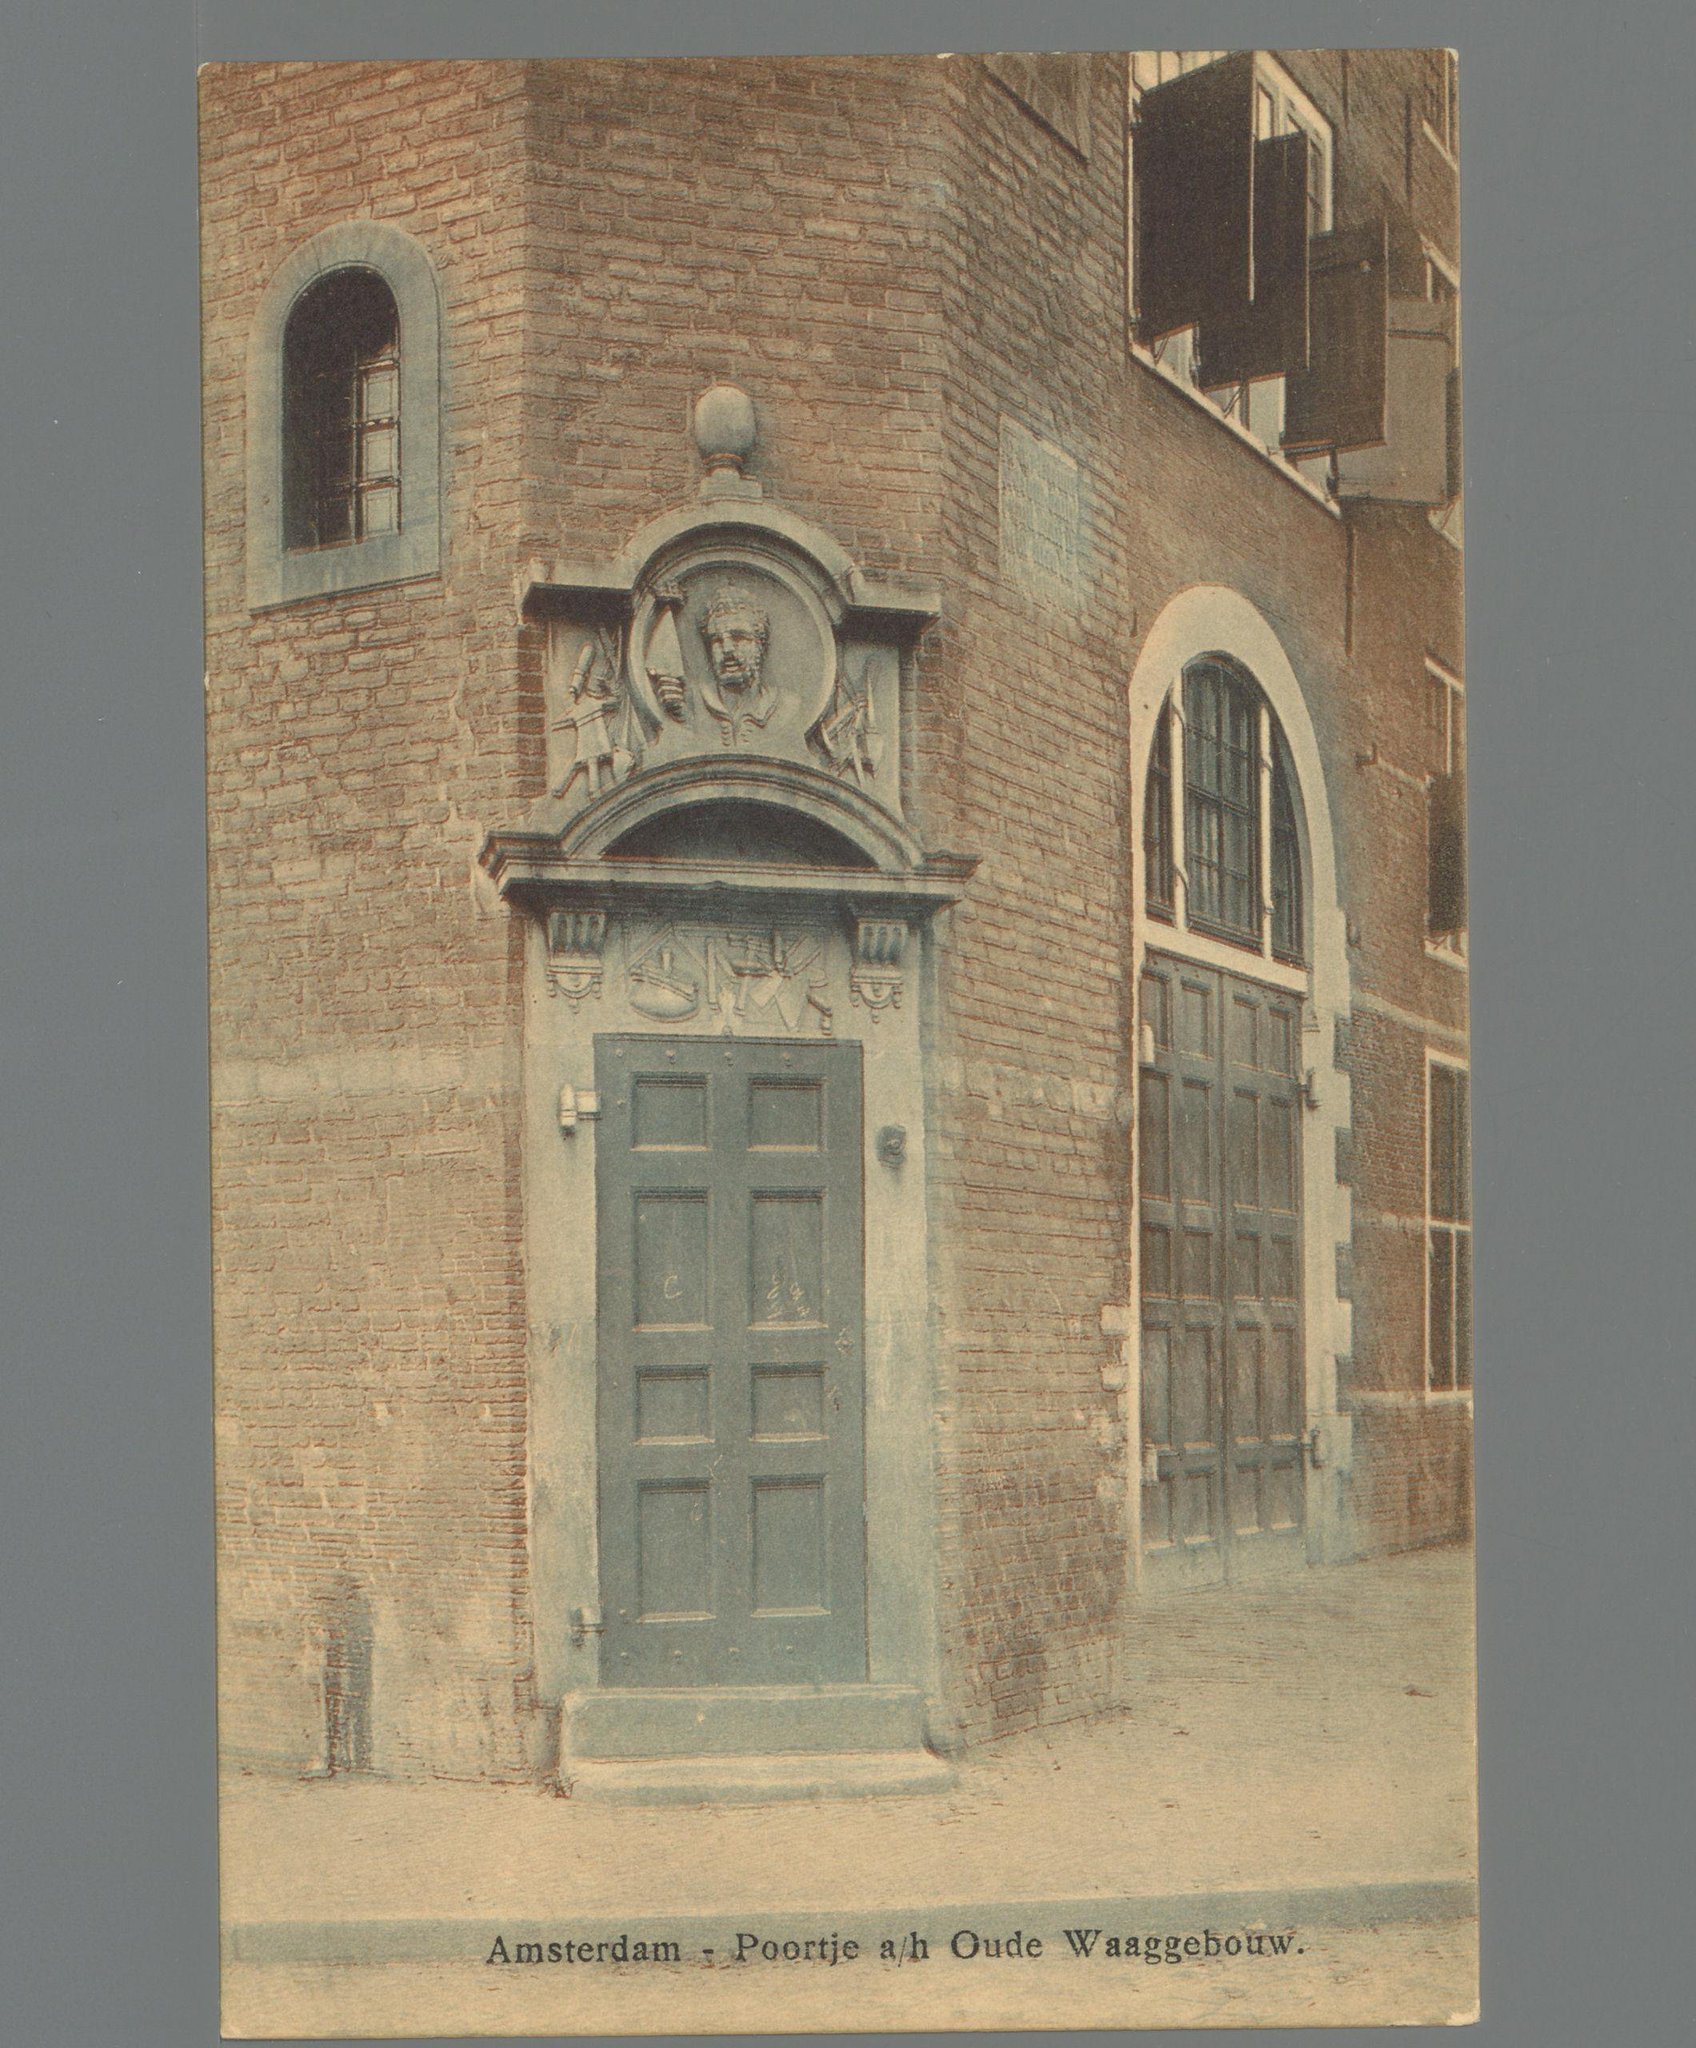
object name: photomechanical print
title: Amsterdam - Poortje a/h Oude Waaggebouw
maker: Anonymous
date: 1910-1912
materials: cardboard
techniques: collotype process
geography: amsterdam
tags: gate, entrance